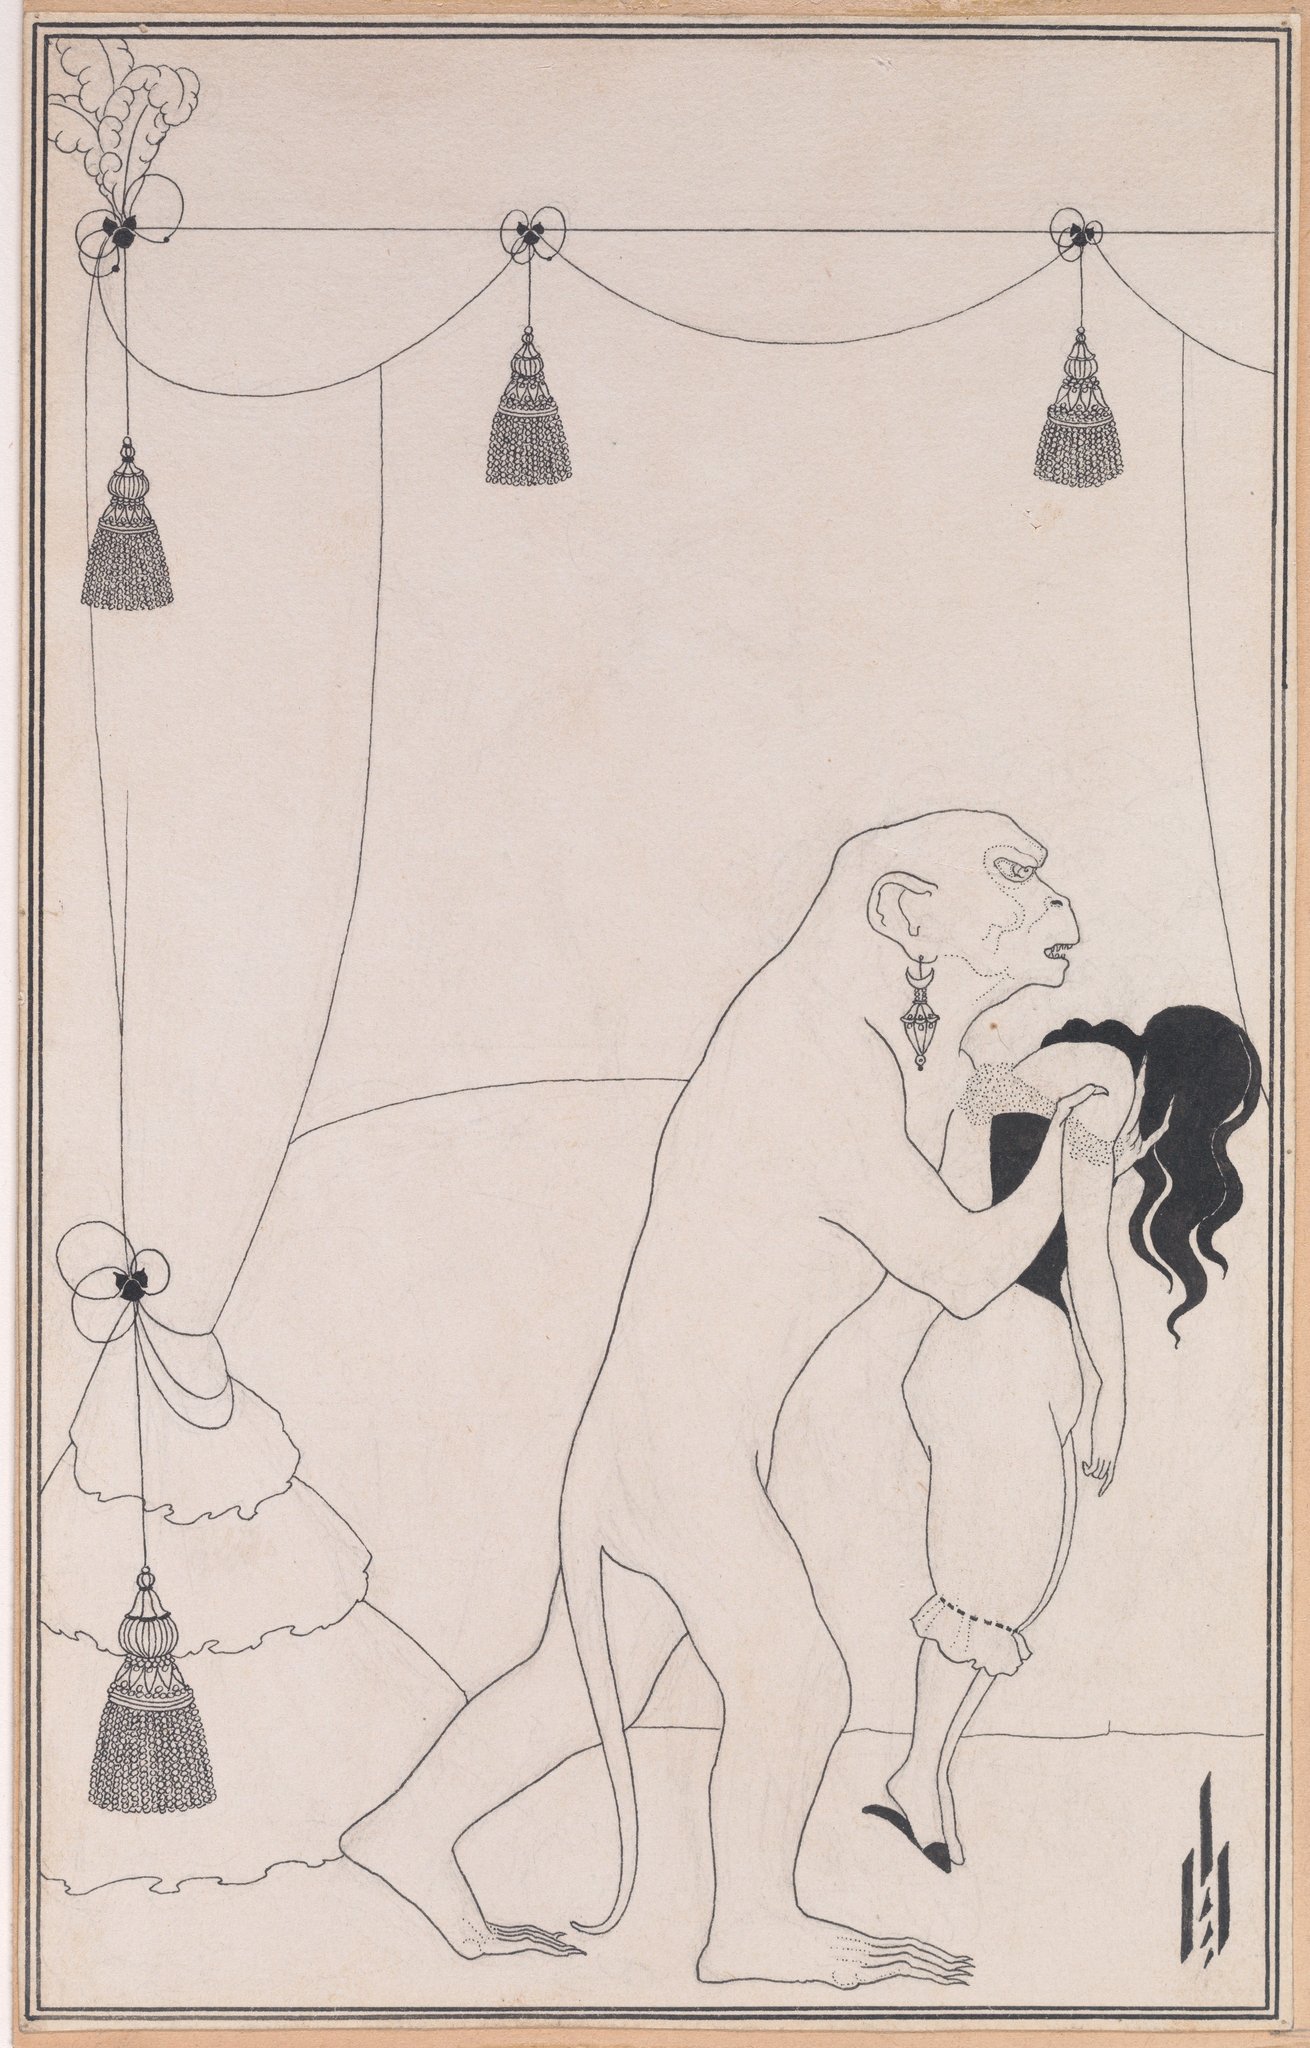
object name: drawing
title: The Murders in the Rue Morgue, for Edgar Allan Poe’s “Tales of Mystery and the Imagination,” Chicago, 1895–96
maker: aubrey vincent beardsley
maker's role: artist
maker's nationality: british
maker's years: 1872-1898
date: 1894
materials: graphite, ink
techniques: brush, pen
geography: great britain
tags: animals,women